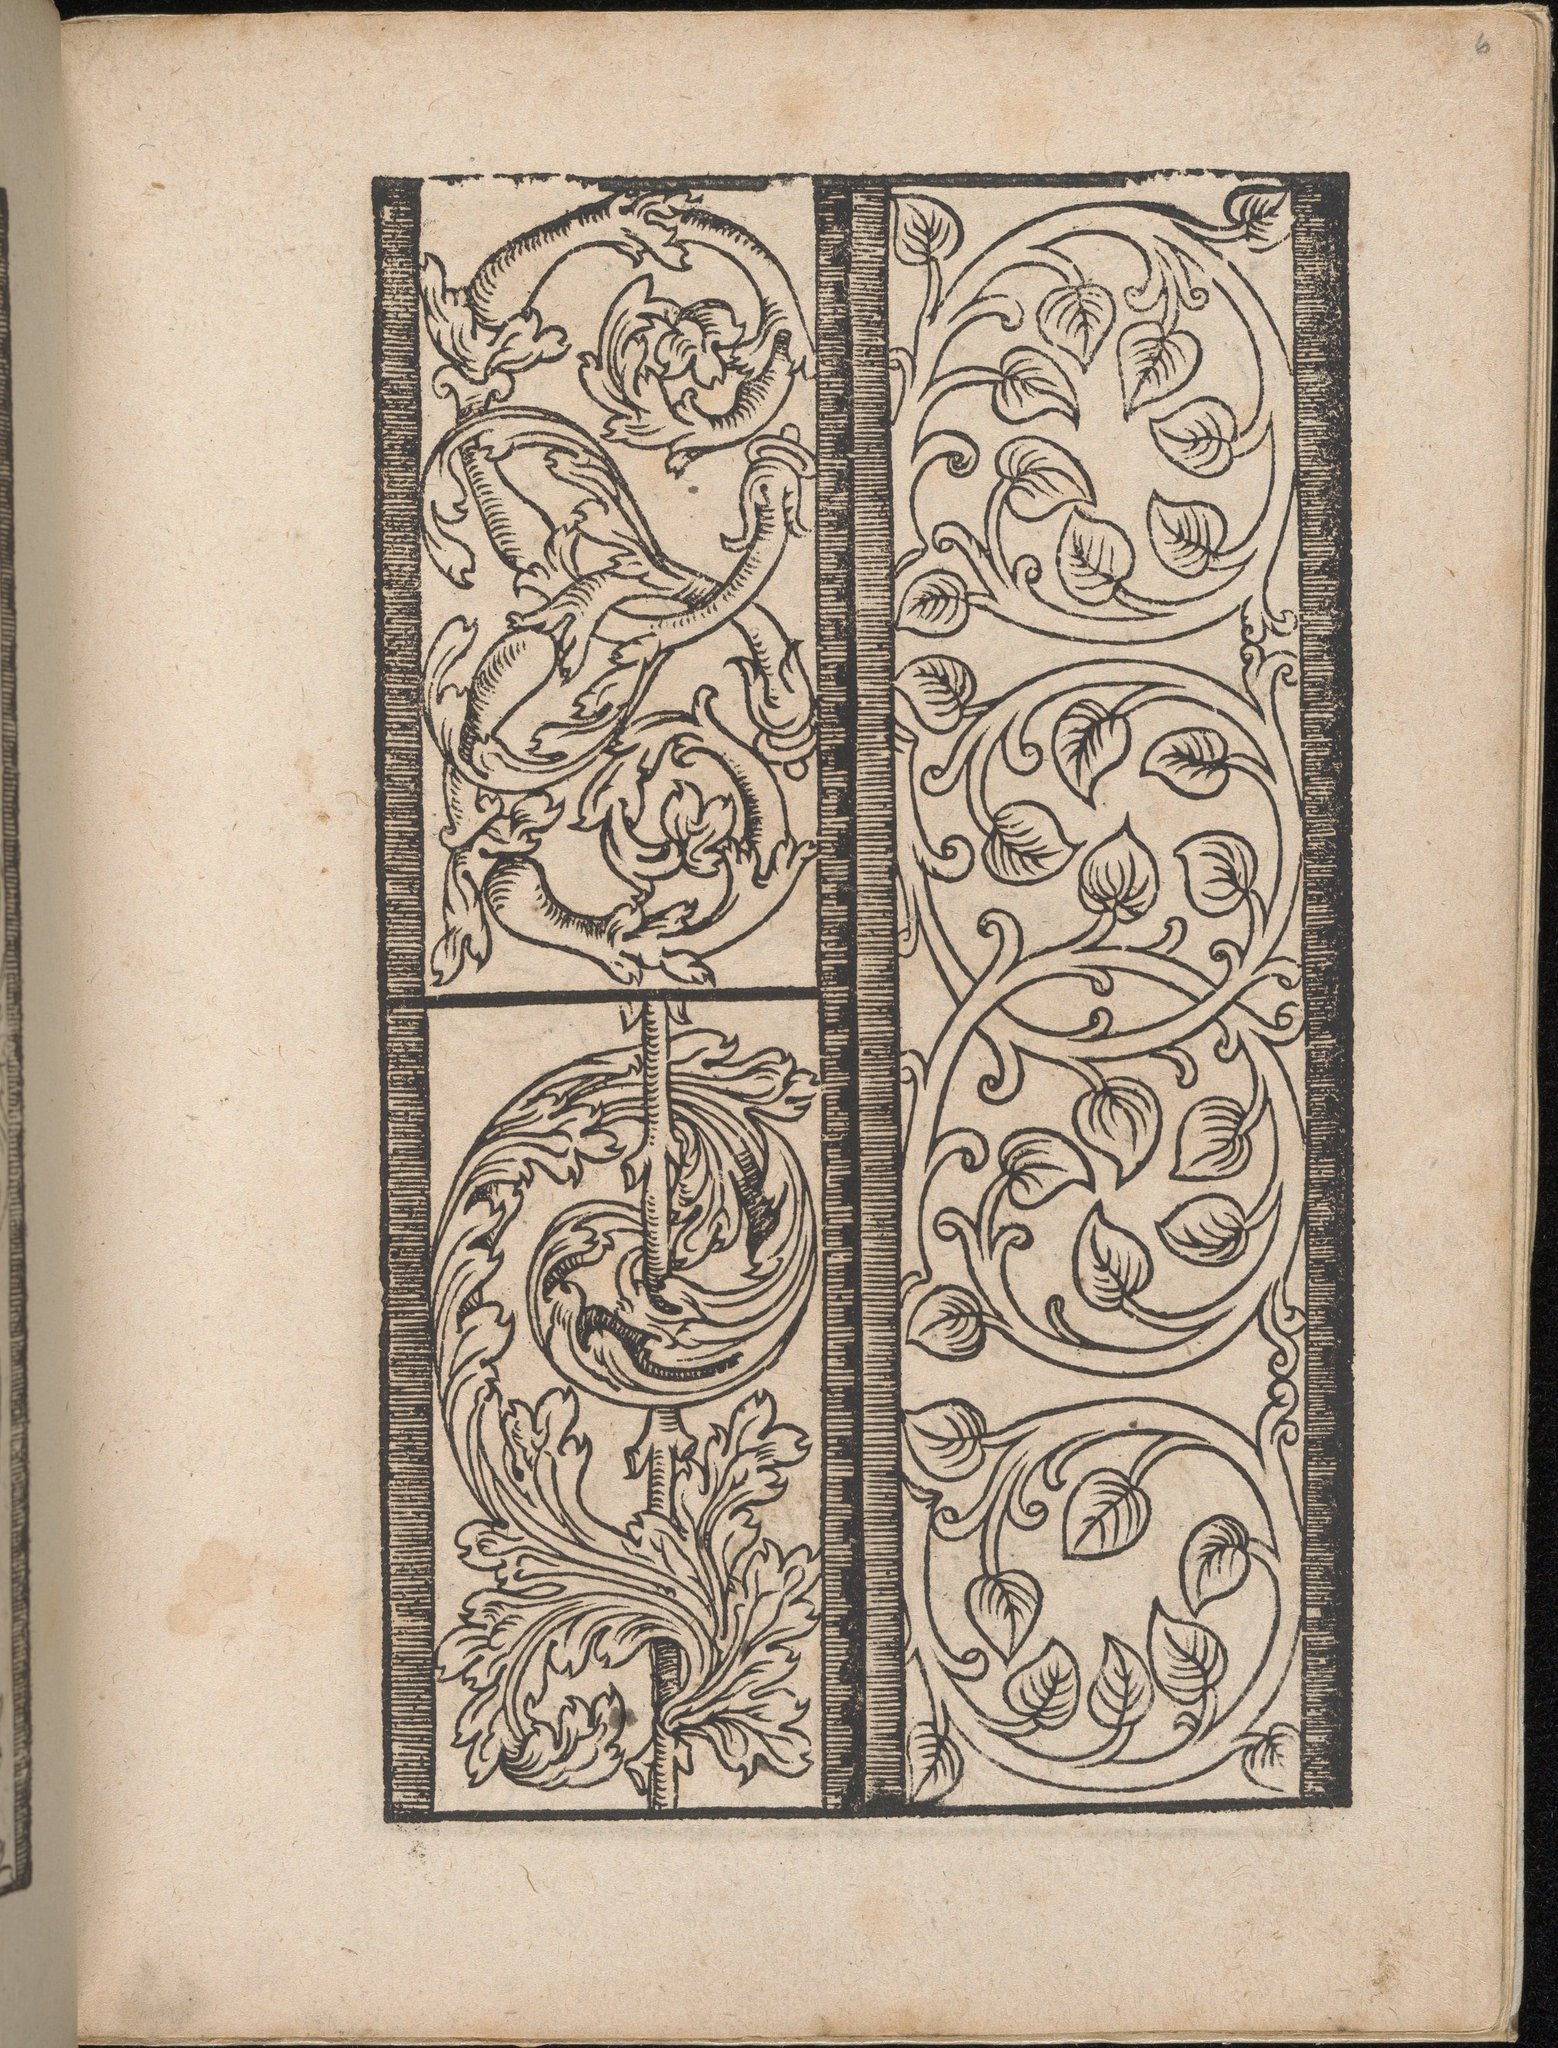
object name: book print ornament architecture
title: Ein new Modelbuch..., page 3 (verso)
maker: johann schönsperger the younger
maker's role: publisher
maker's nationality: german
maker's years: 1490-1550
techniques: woodcut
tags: acanthus